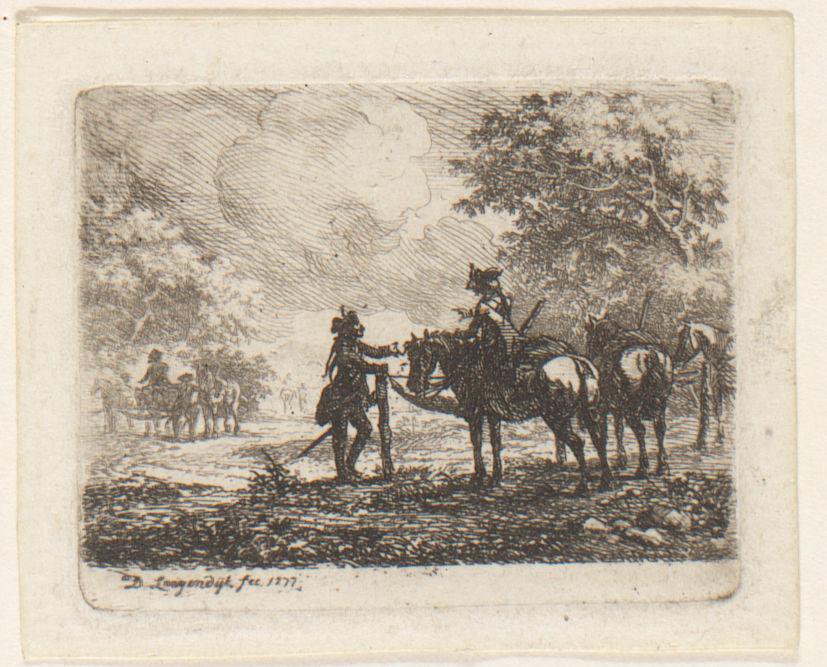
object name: print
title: Landschap met een watermolen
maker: jan luyken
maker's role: draughtsman, print maker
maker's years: 1649-1712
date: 1711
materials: paper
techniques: etching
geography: amsterdam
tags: watermill in landscape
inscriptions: collector's mark: Lugt 2228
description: Illustratie voor: Luyken, Jan. De Bykorf des Gemoeds. Amsterdam: Pieter Arentsz. II (wed.) en Cornelis van der Sys, 1711, p. 86.